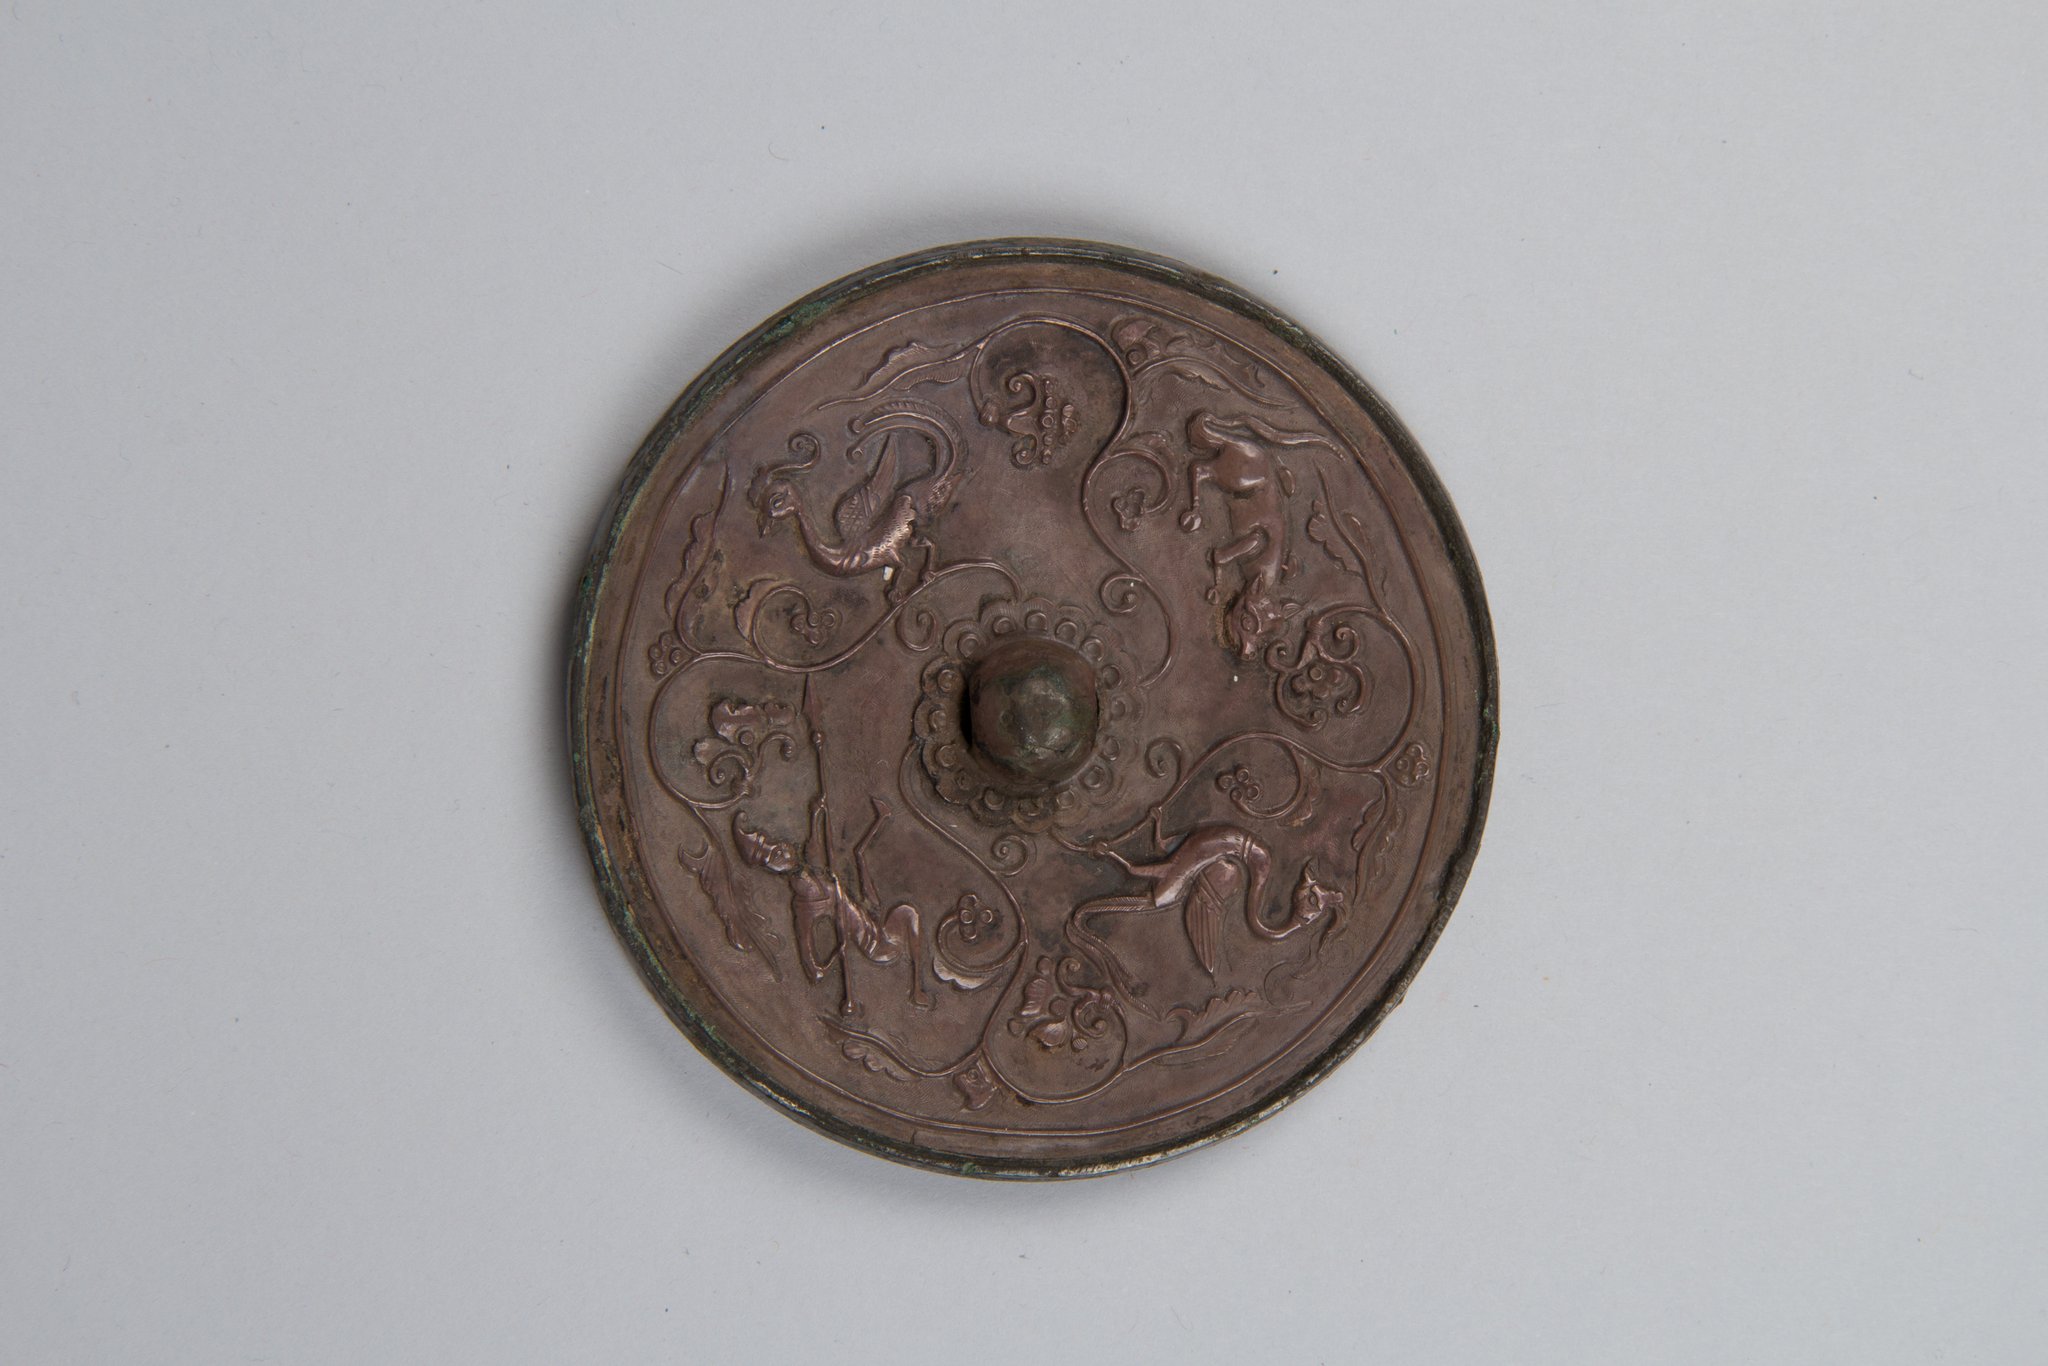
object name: mirror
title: Mirror in the style of the Tang dynasty (618-907)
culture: chinese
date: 1801-2000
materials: bronze, silver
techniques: repoussé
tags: animals,birds